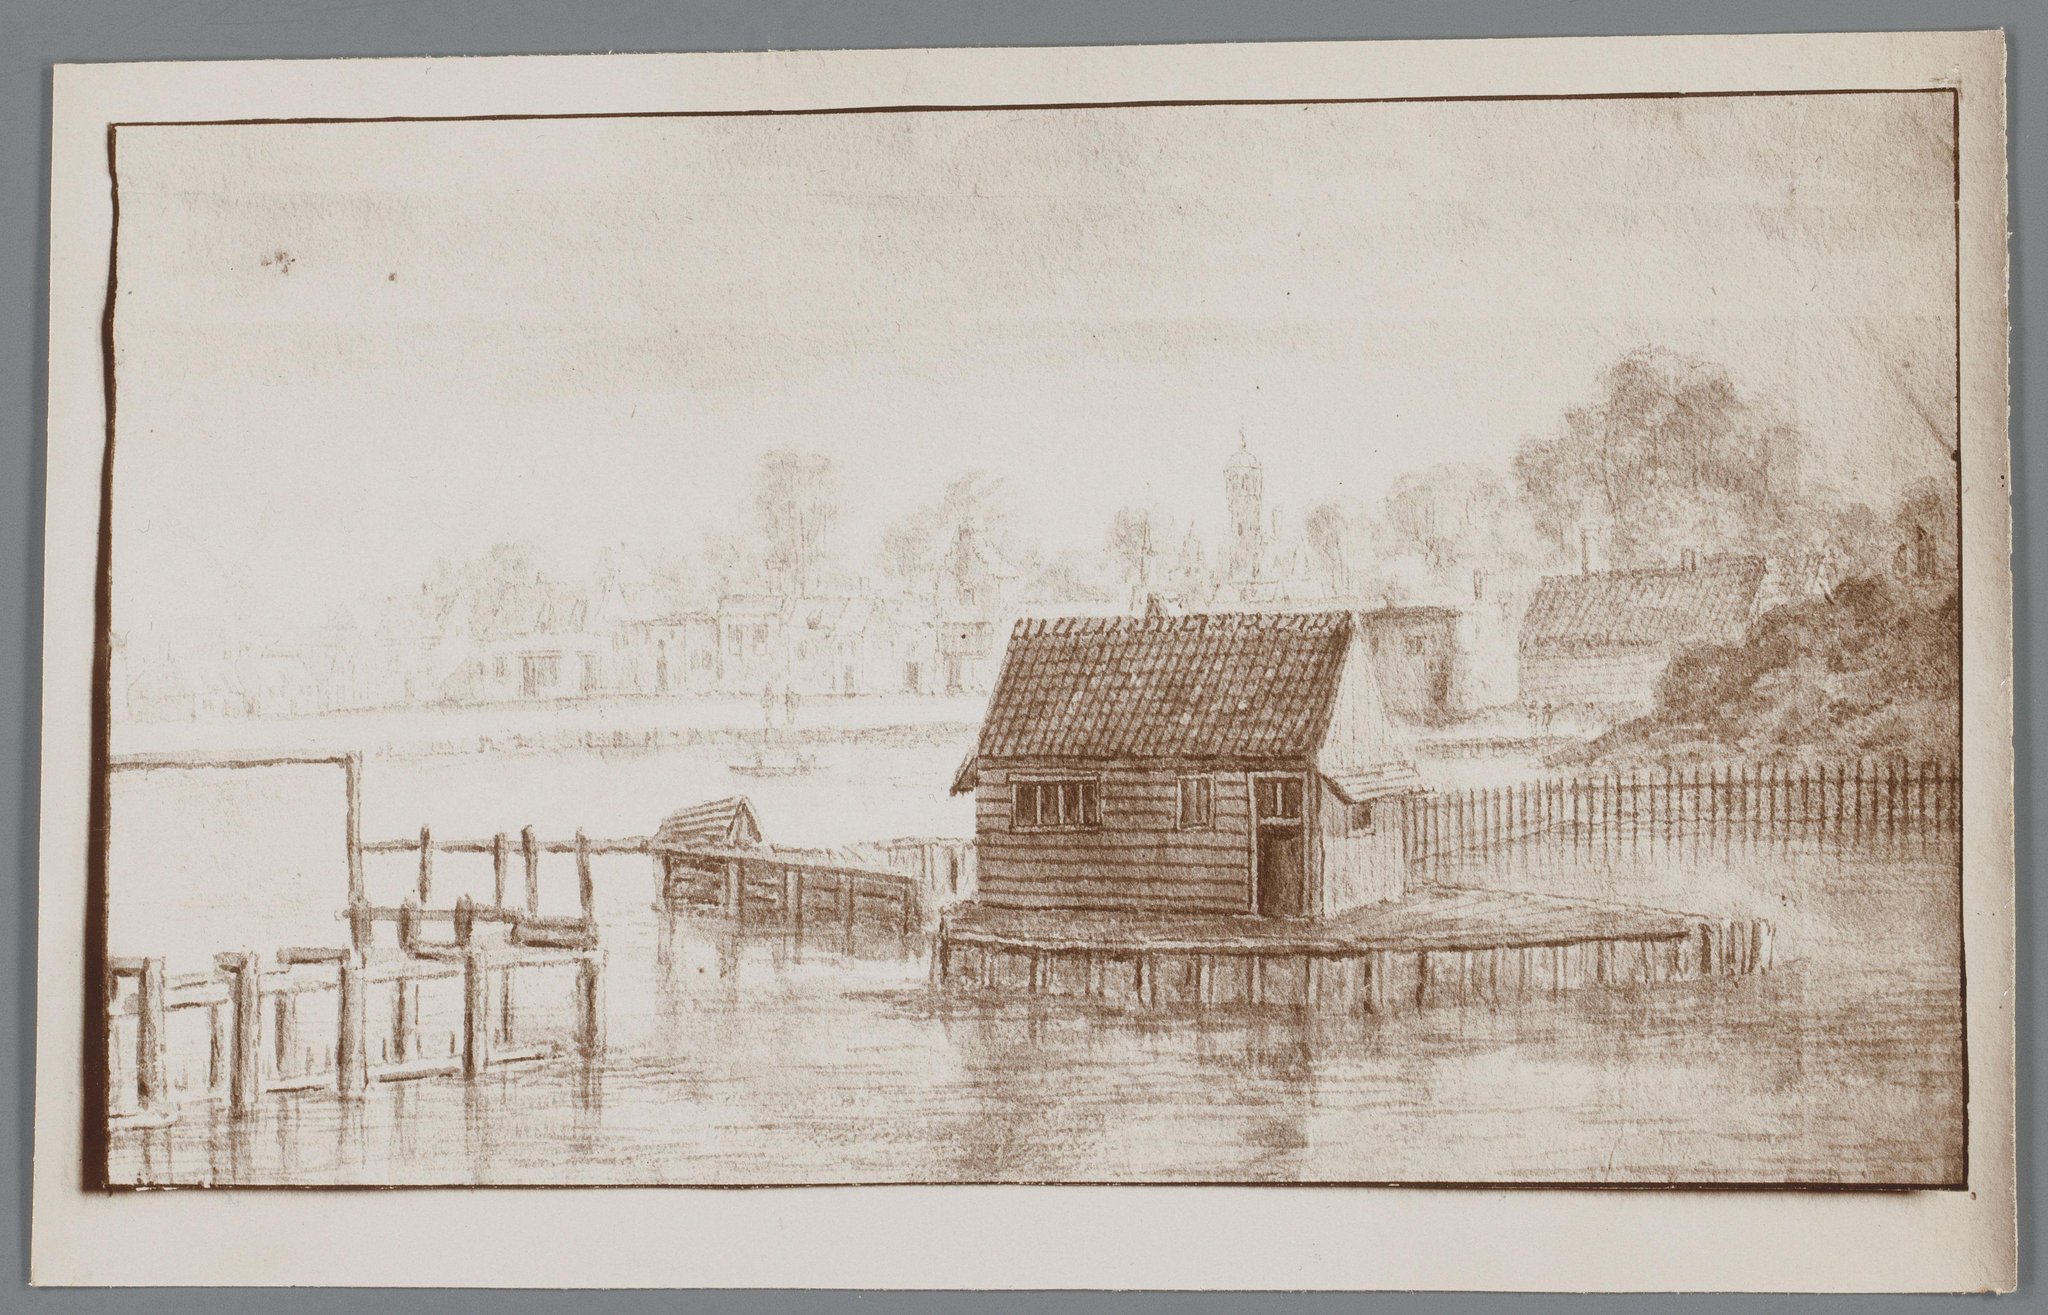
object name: reproduction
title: Fotoreproductie van een tekening van een huis aan het water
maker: Anonymous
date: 1880-1920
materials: paper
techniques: gelatin silver print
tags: water course, cottage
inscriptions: number: ‘391.’